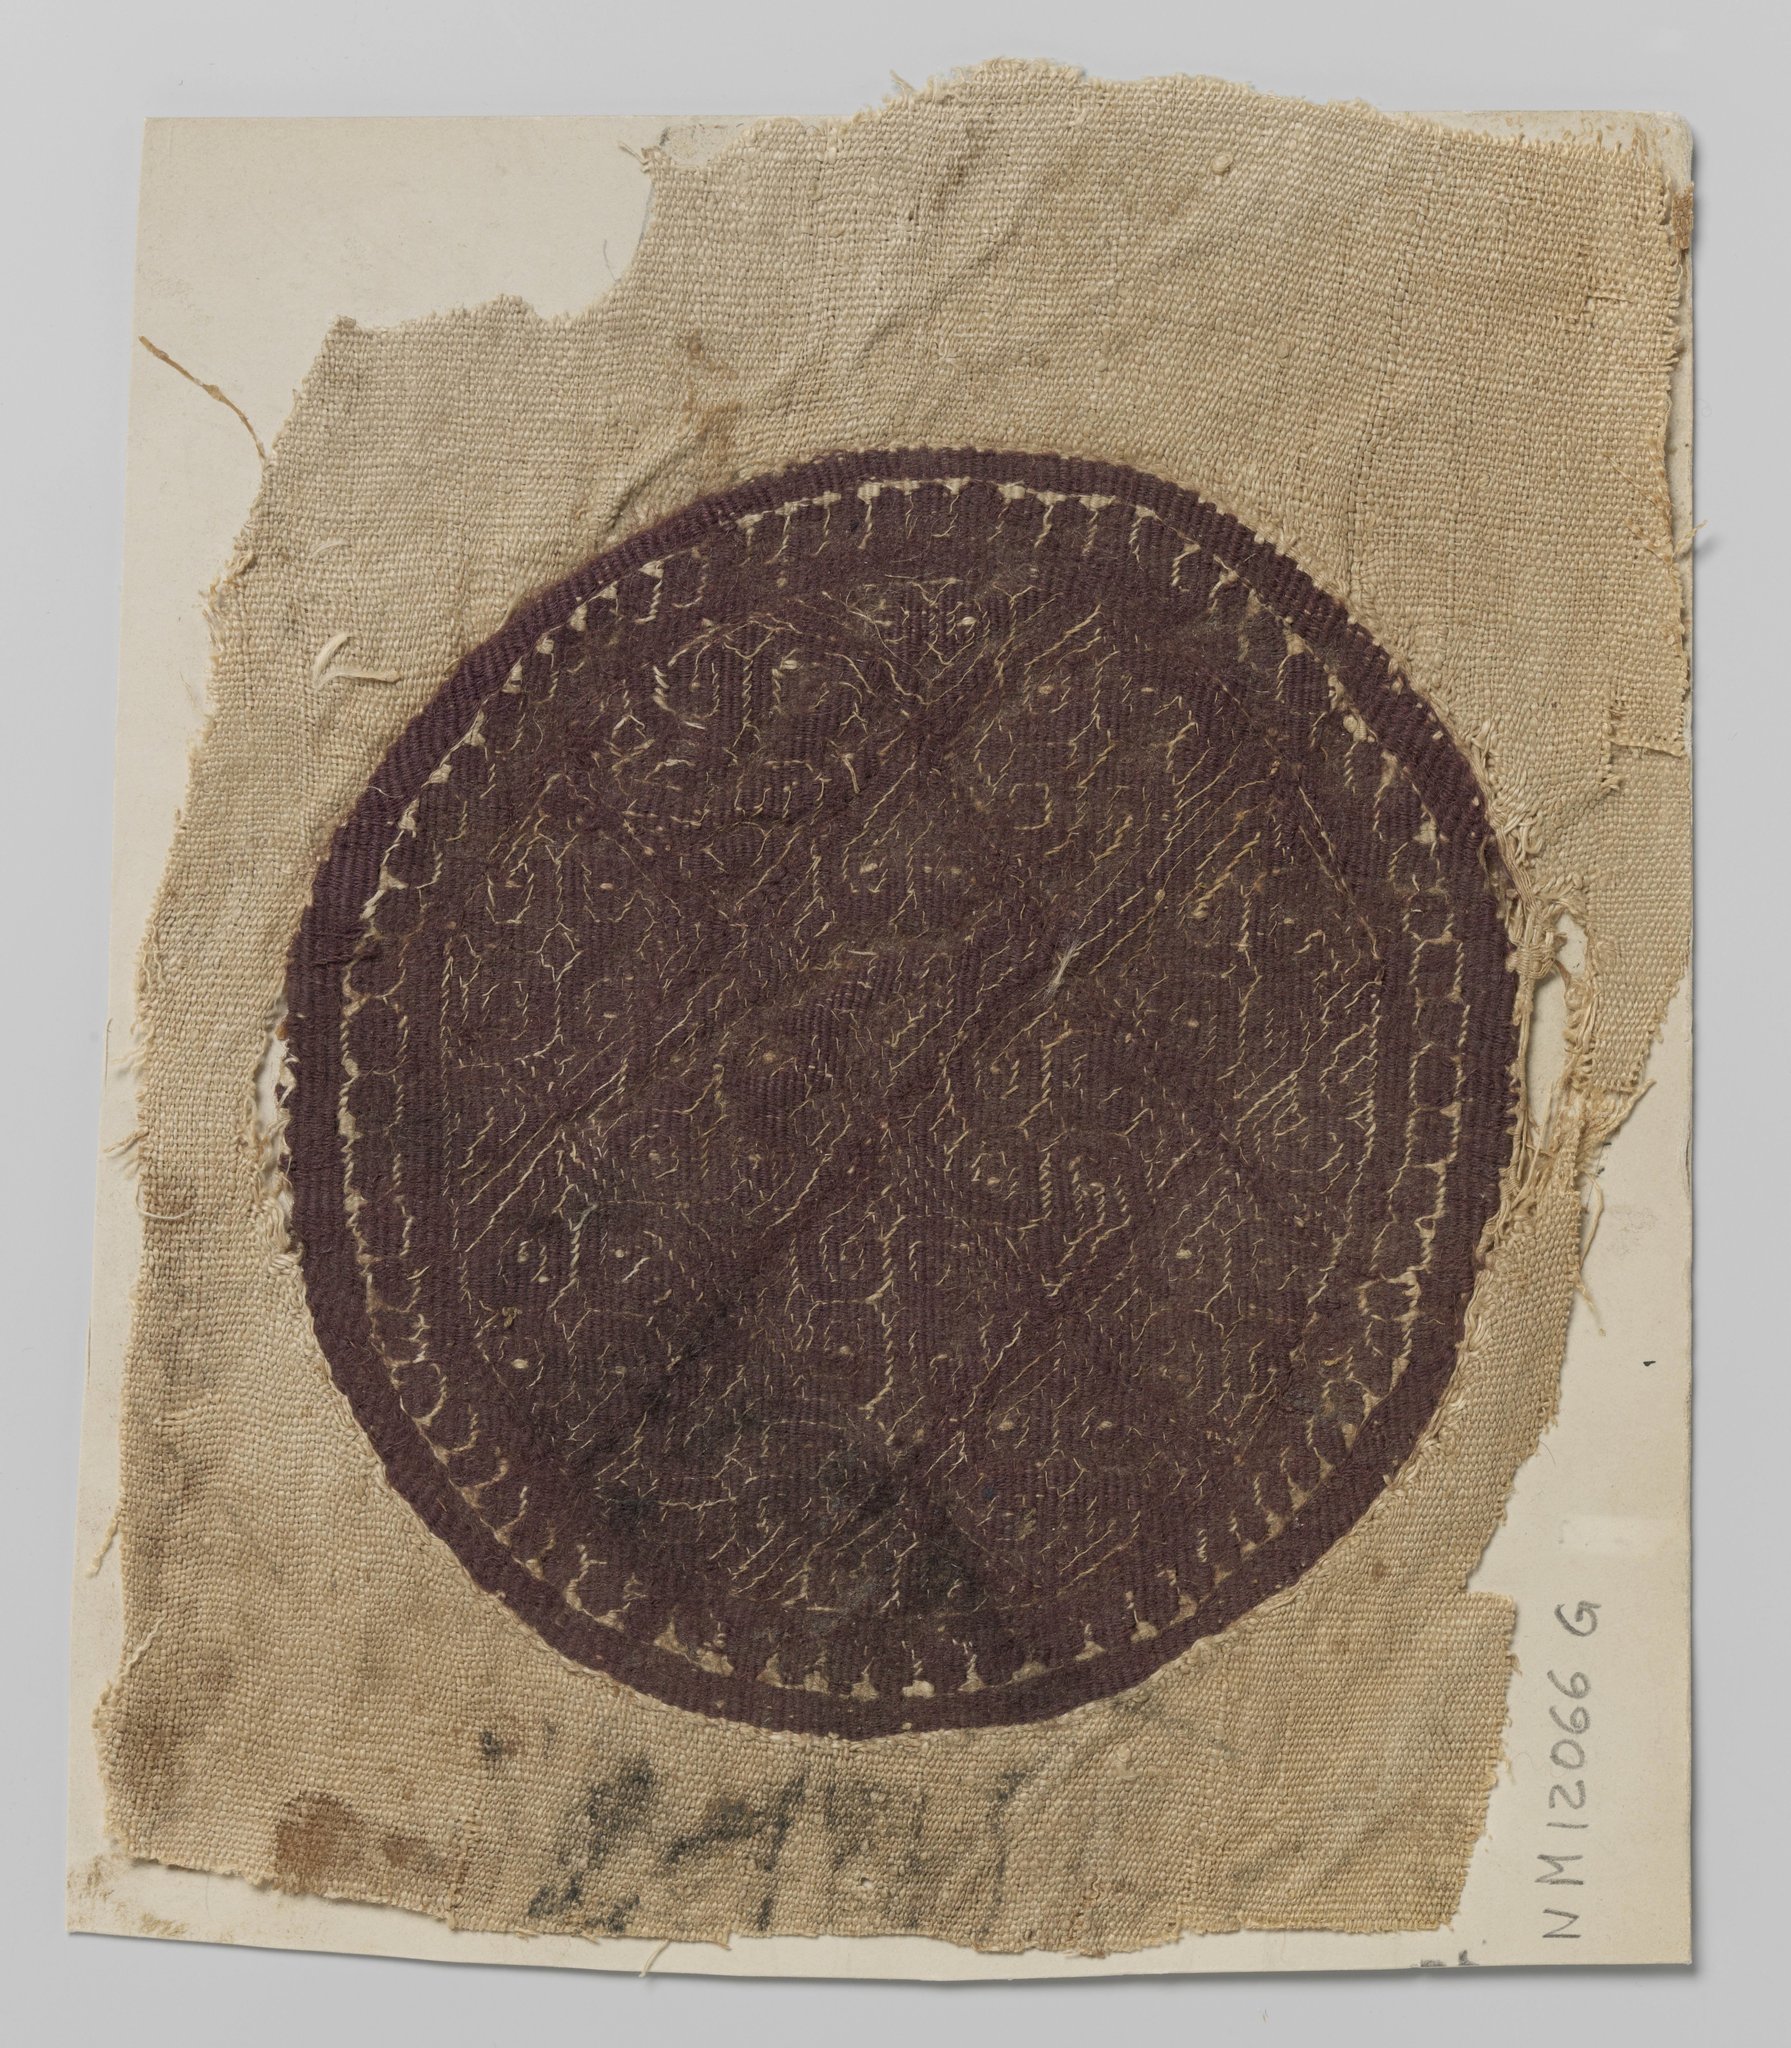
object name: orbiculus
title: Weefselfragment met orbiculus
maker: Anonymous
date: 300-499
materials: linen, wool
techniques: weave, tapestry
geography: egypt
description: Naturelkleurig linnen weefselfragment met ingeweven orbiculus in tapisserietechniek in paarse wol, met een naturelkleurig geometrisch motief in vliegende draadtechniek van ruiten en cirkels omgeven door een parelrand.